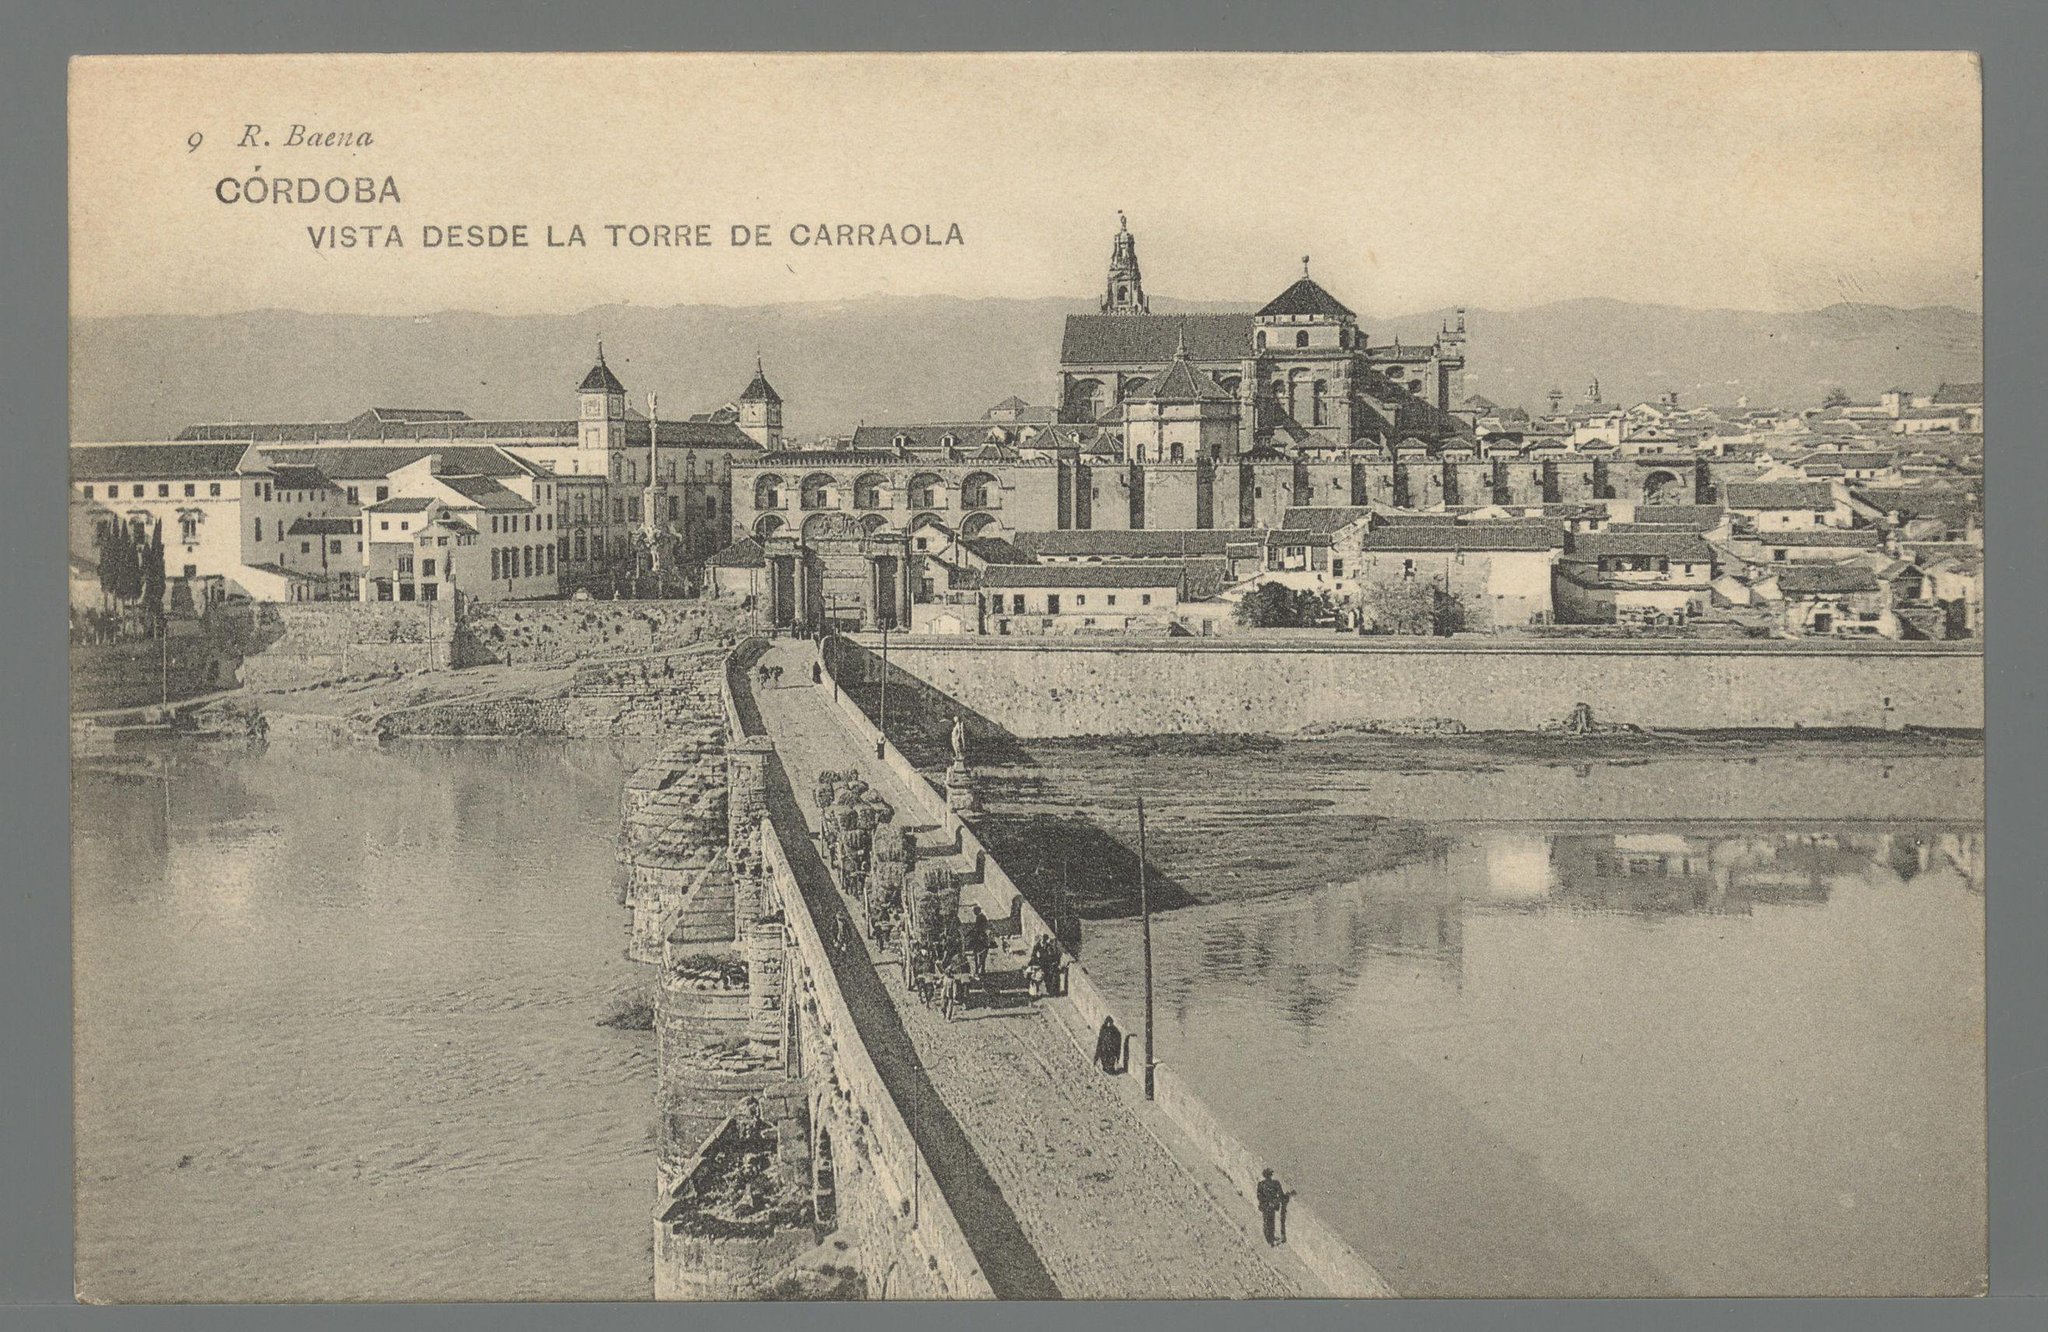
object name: ansichtkaart, prentbriefkaart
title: R. Baena. Córdoba. Vista desde la torre de Carraola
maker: Anonymous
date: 1906-1930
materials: cardboard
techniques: photograph, writing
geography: córdoba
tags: church (exterior), canals, waters (in city), bridge in city across river, canal, etc.